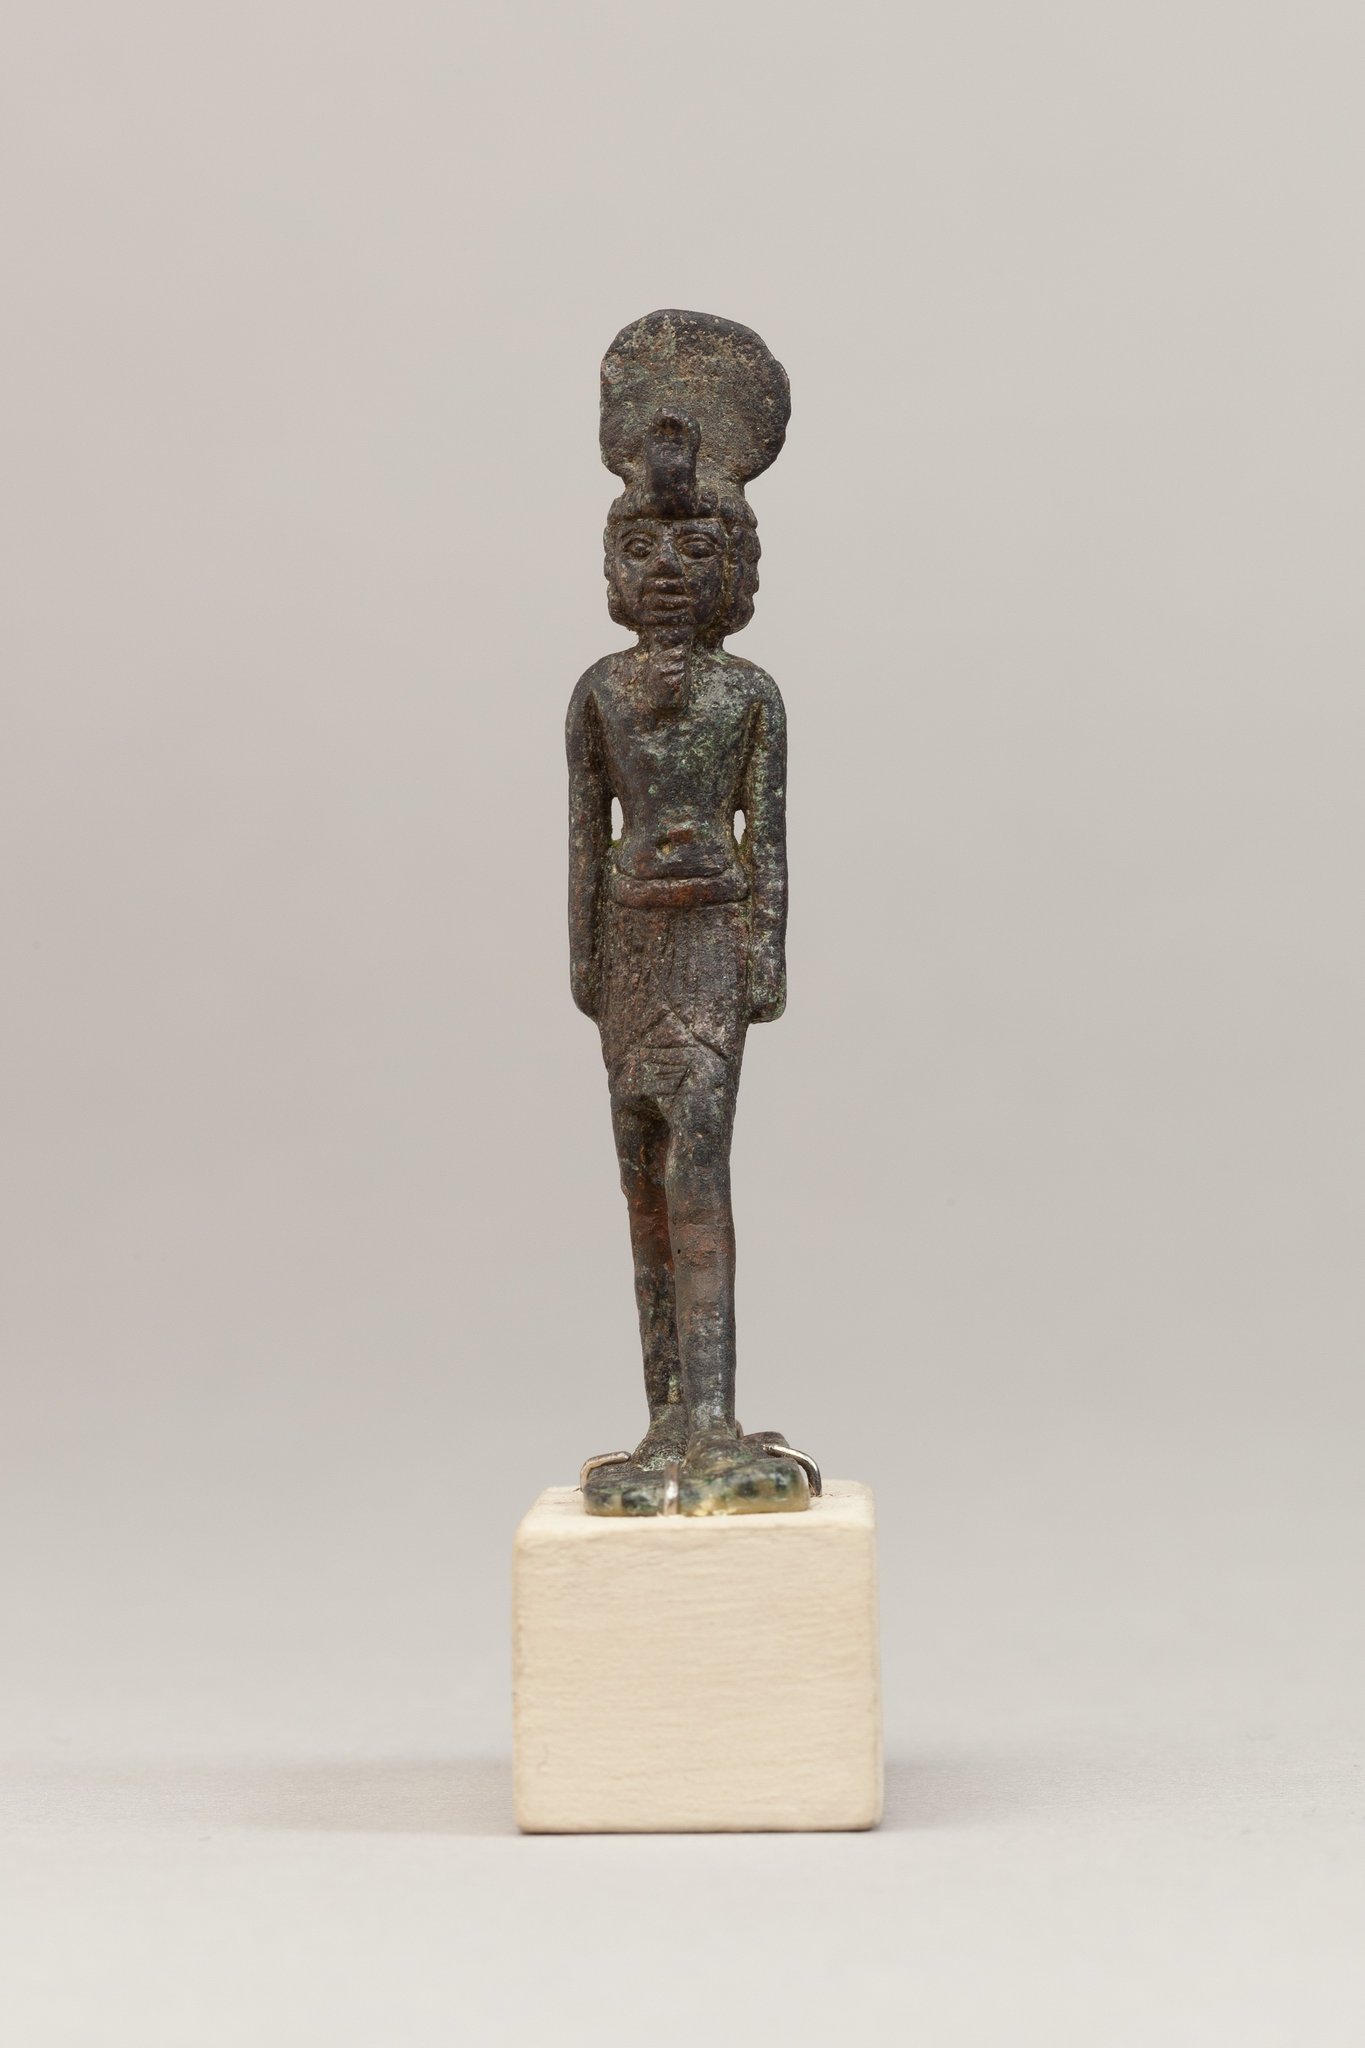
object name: amulet, god, disk, uraeus, short wig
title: God wearing disk and uraeus on a short wig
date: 664-630 BCE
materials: metal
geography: egypt